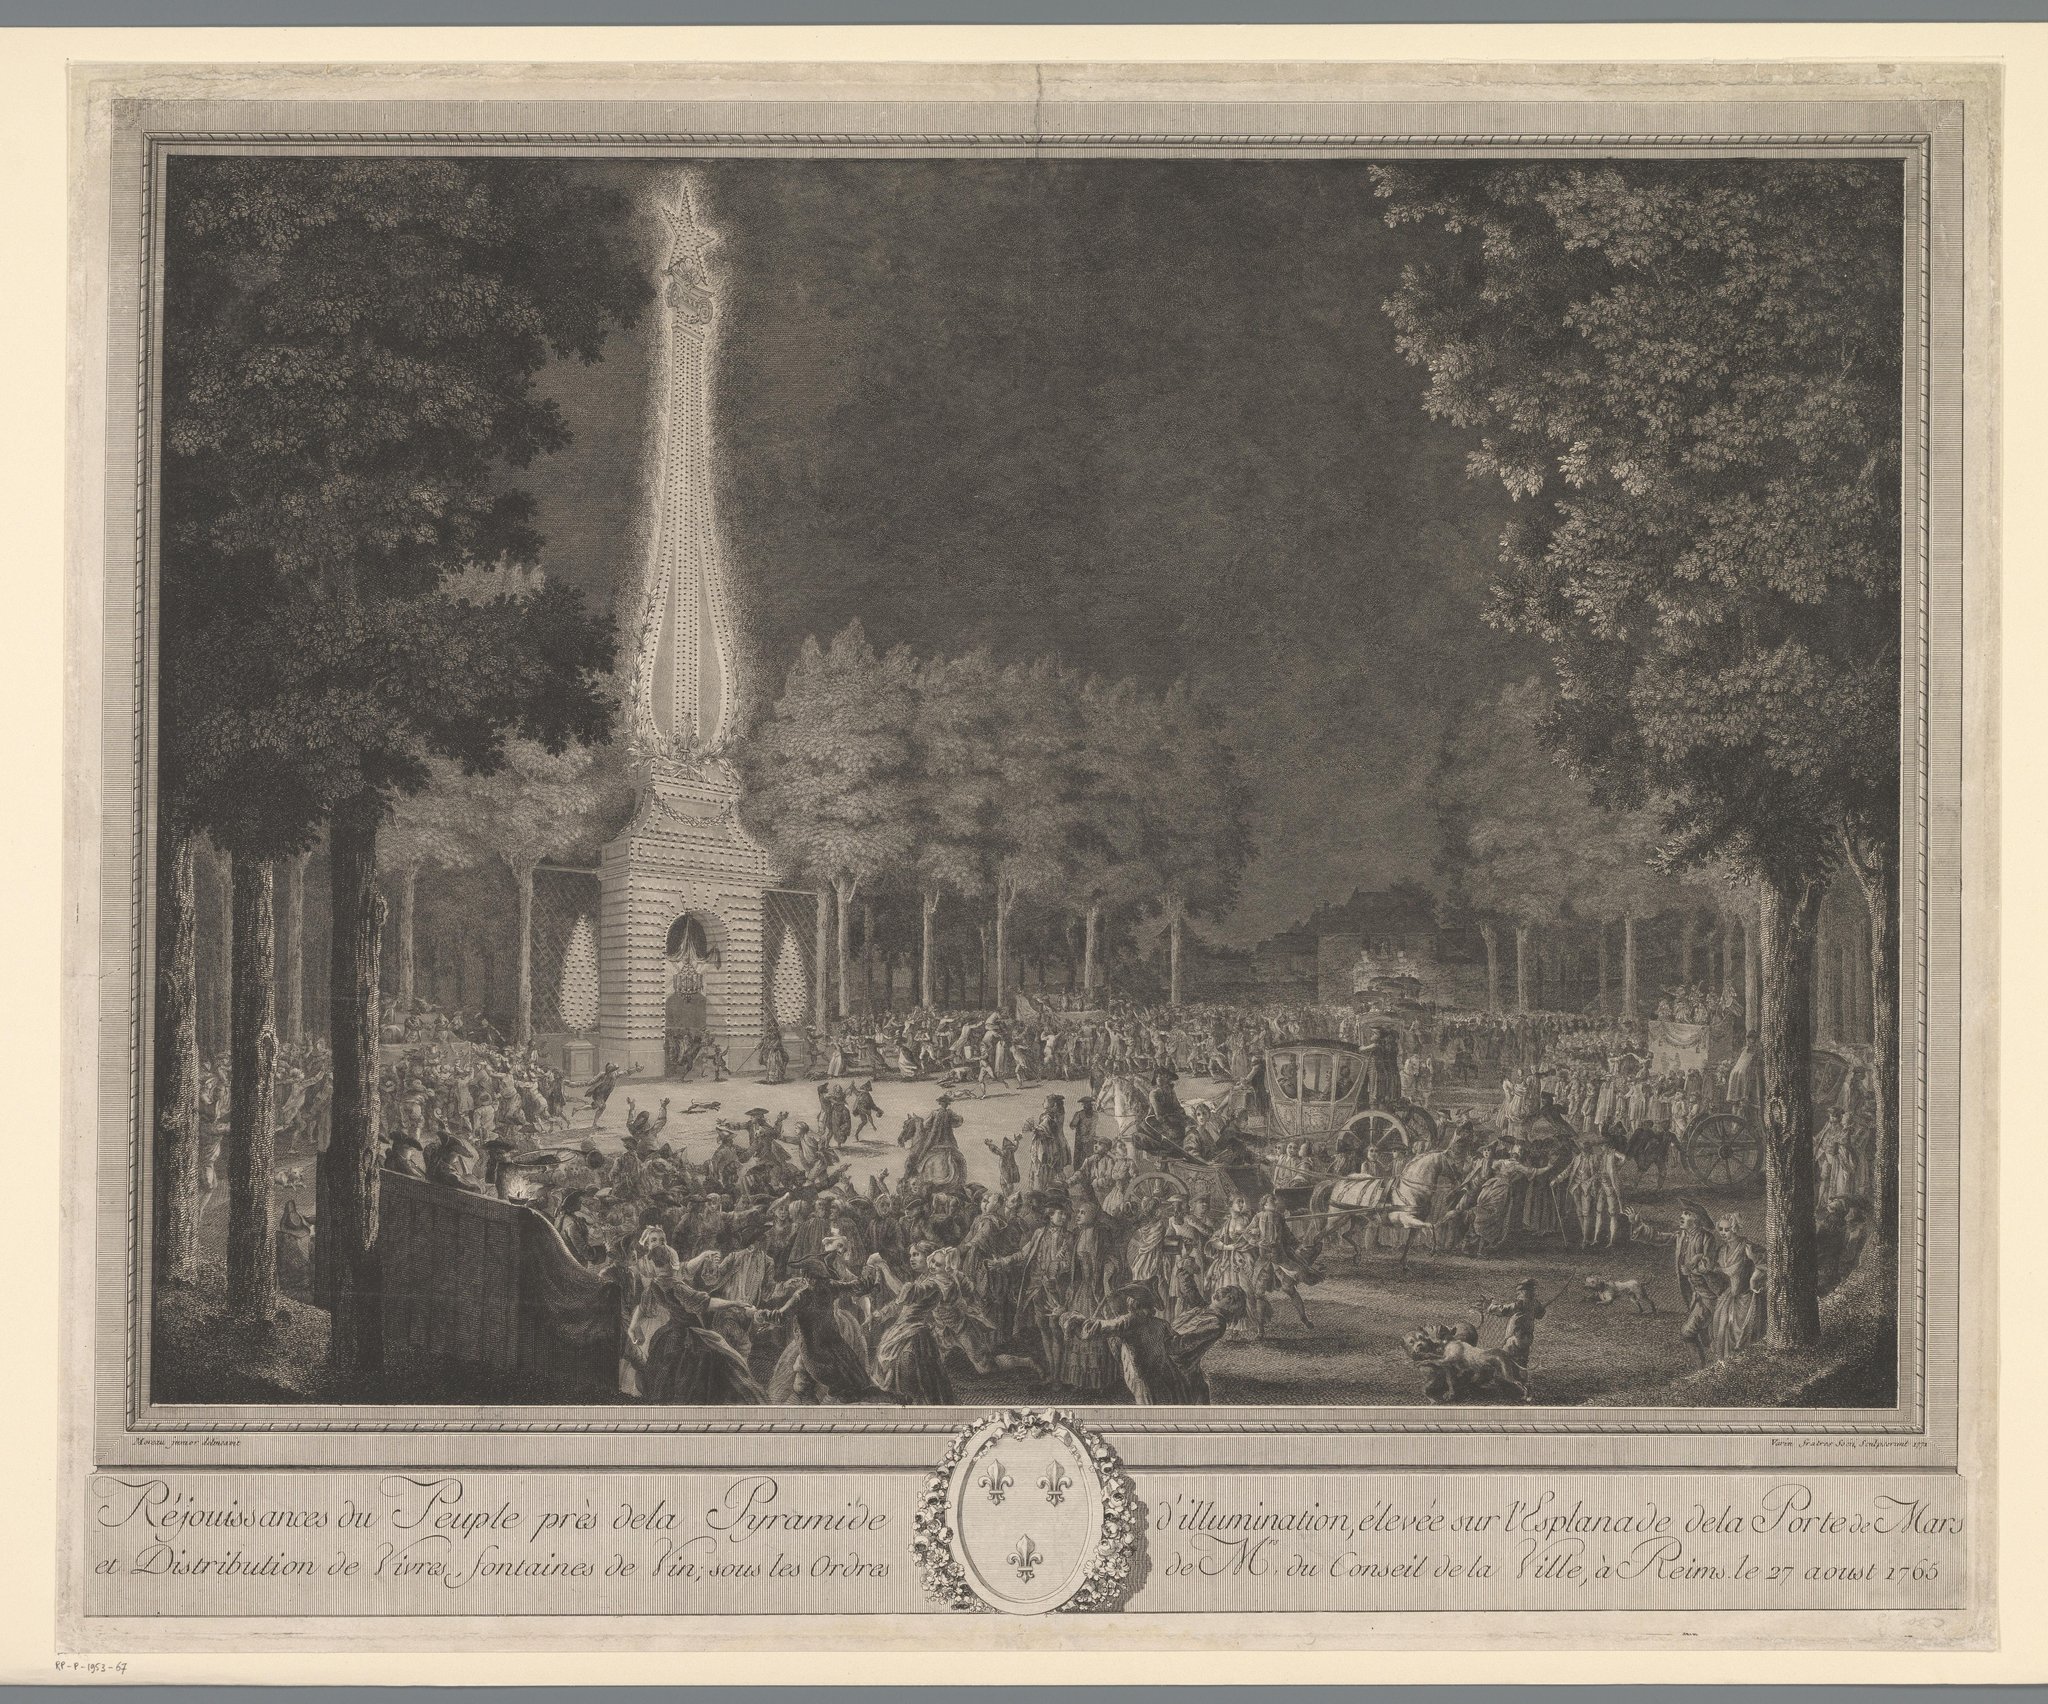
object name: print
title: Réjouissances du peuple près de la Pyramide d'illumination, élevée sur l'esplanade de la porte de Mars et distribution de vivres, fontaines de vin, sous les ordres de M.rs du Conseil de la ville à Reims, le 27 aoust 1765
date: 1771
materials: paper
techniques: engraving, etching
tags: public festivities, candle, passenger carriage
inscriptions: collector's mark: Lugt 2228, collector's mark: Lugt 2760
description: Maakt waarschijnlijk deel uit van een vierdelige serie met feestelijkheden te Reims, gegeven tijdens de inauguratie van een beeld van Lodewijk XV in 1765.